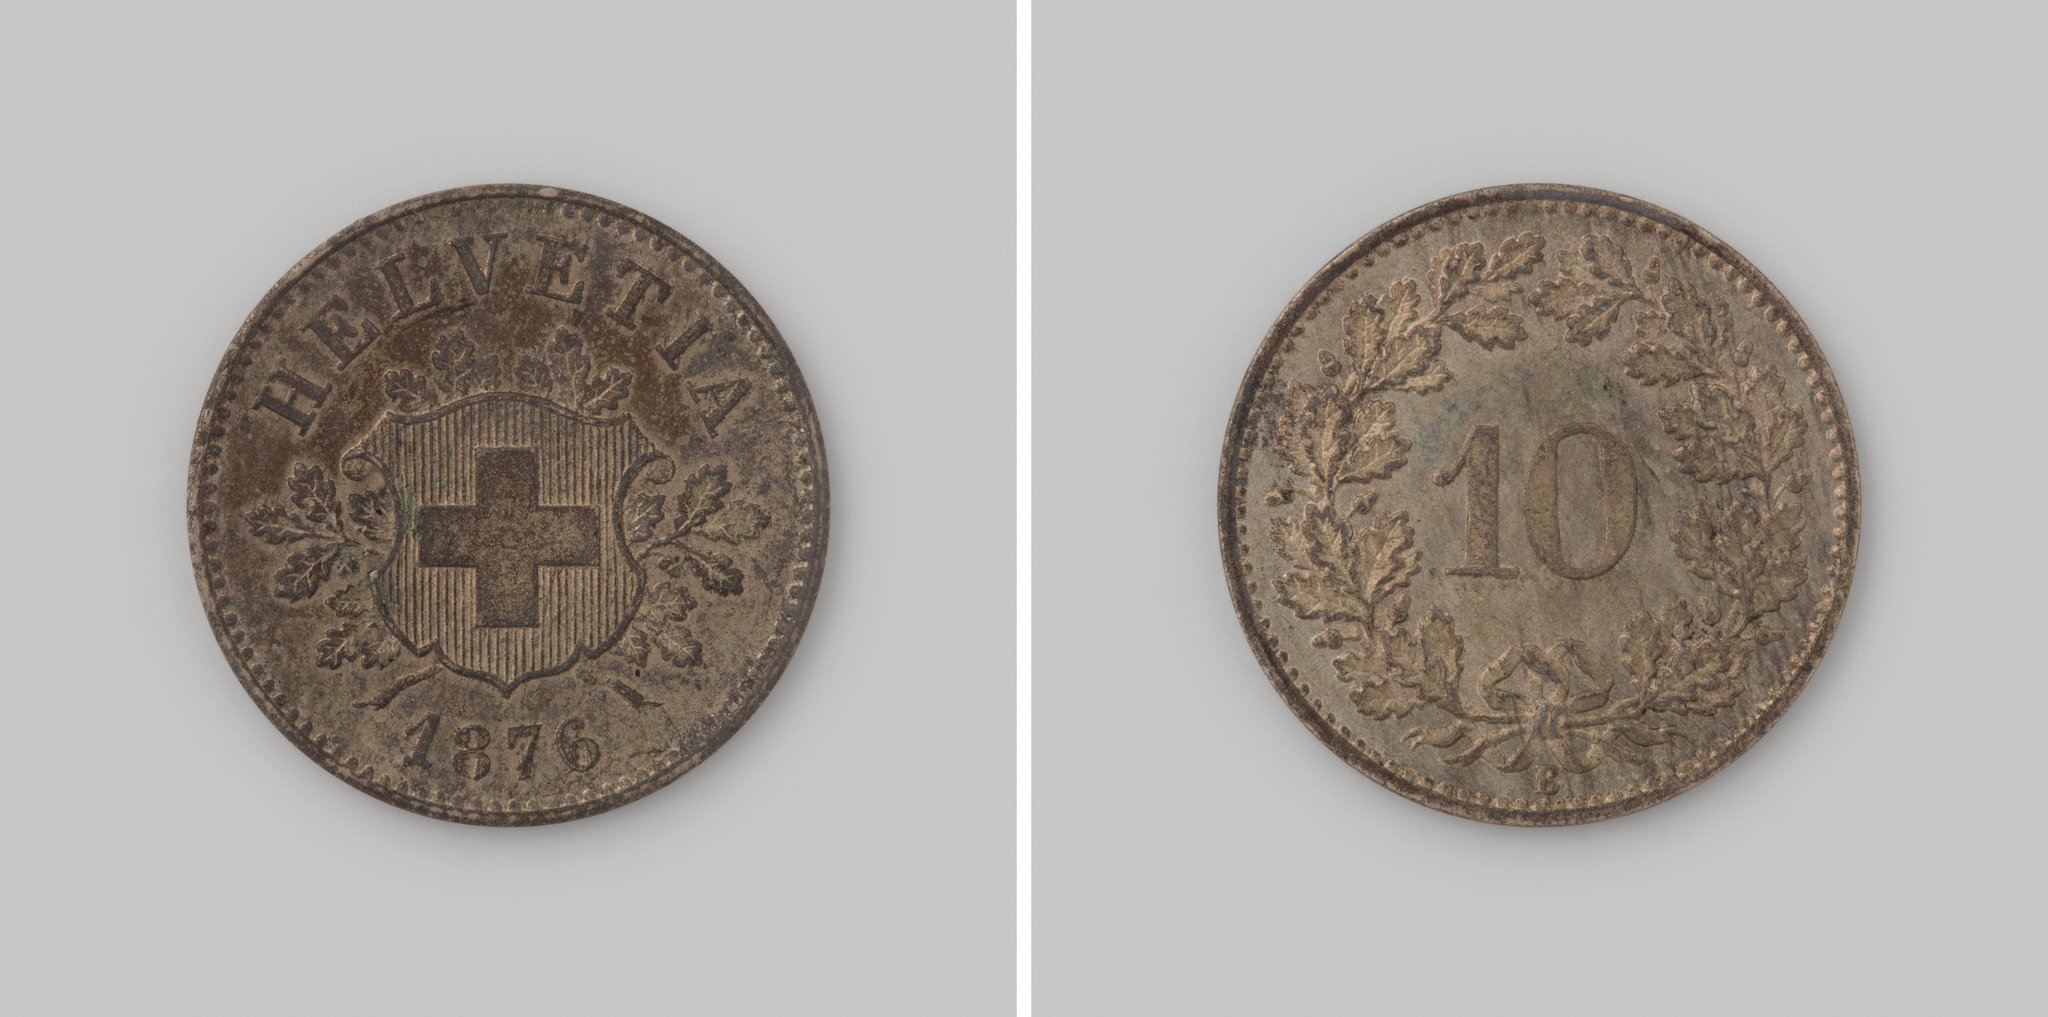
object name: coin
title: Zwitserland, 10 centimes, 1876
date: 1876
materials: nickel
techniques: striking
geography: bern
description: Nikkelen munt. Voorzijde: het wapenschild van Zwitserland tegen een achtergrond van takken. Jaartal onderaan. Keerzijde: binnen twee samengebonden takken in een regel waarde-aanduiding. Onderaan letter B [=Bern]. Gladde rand.